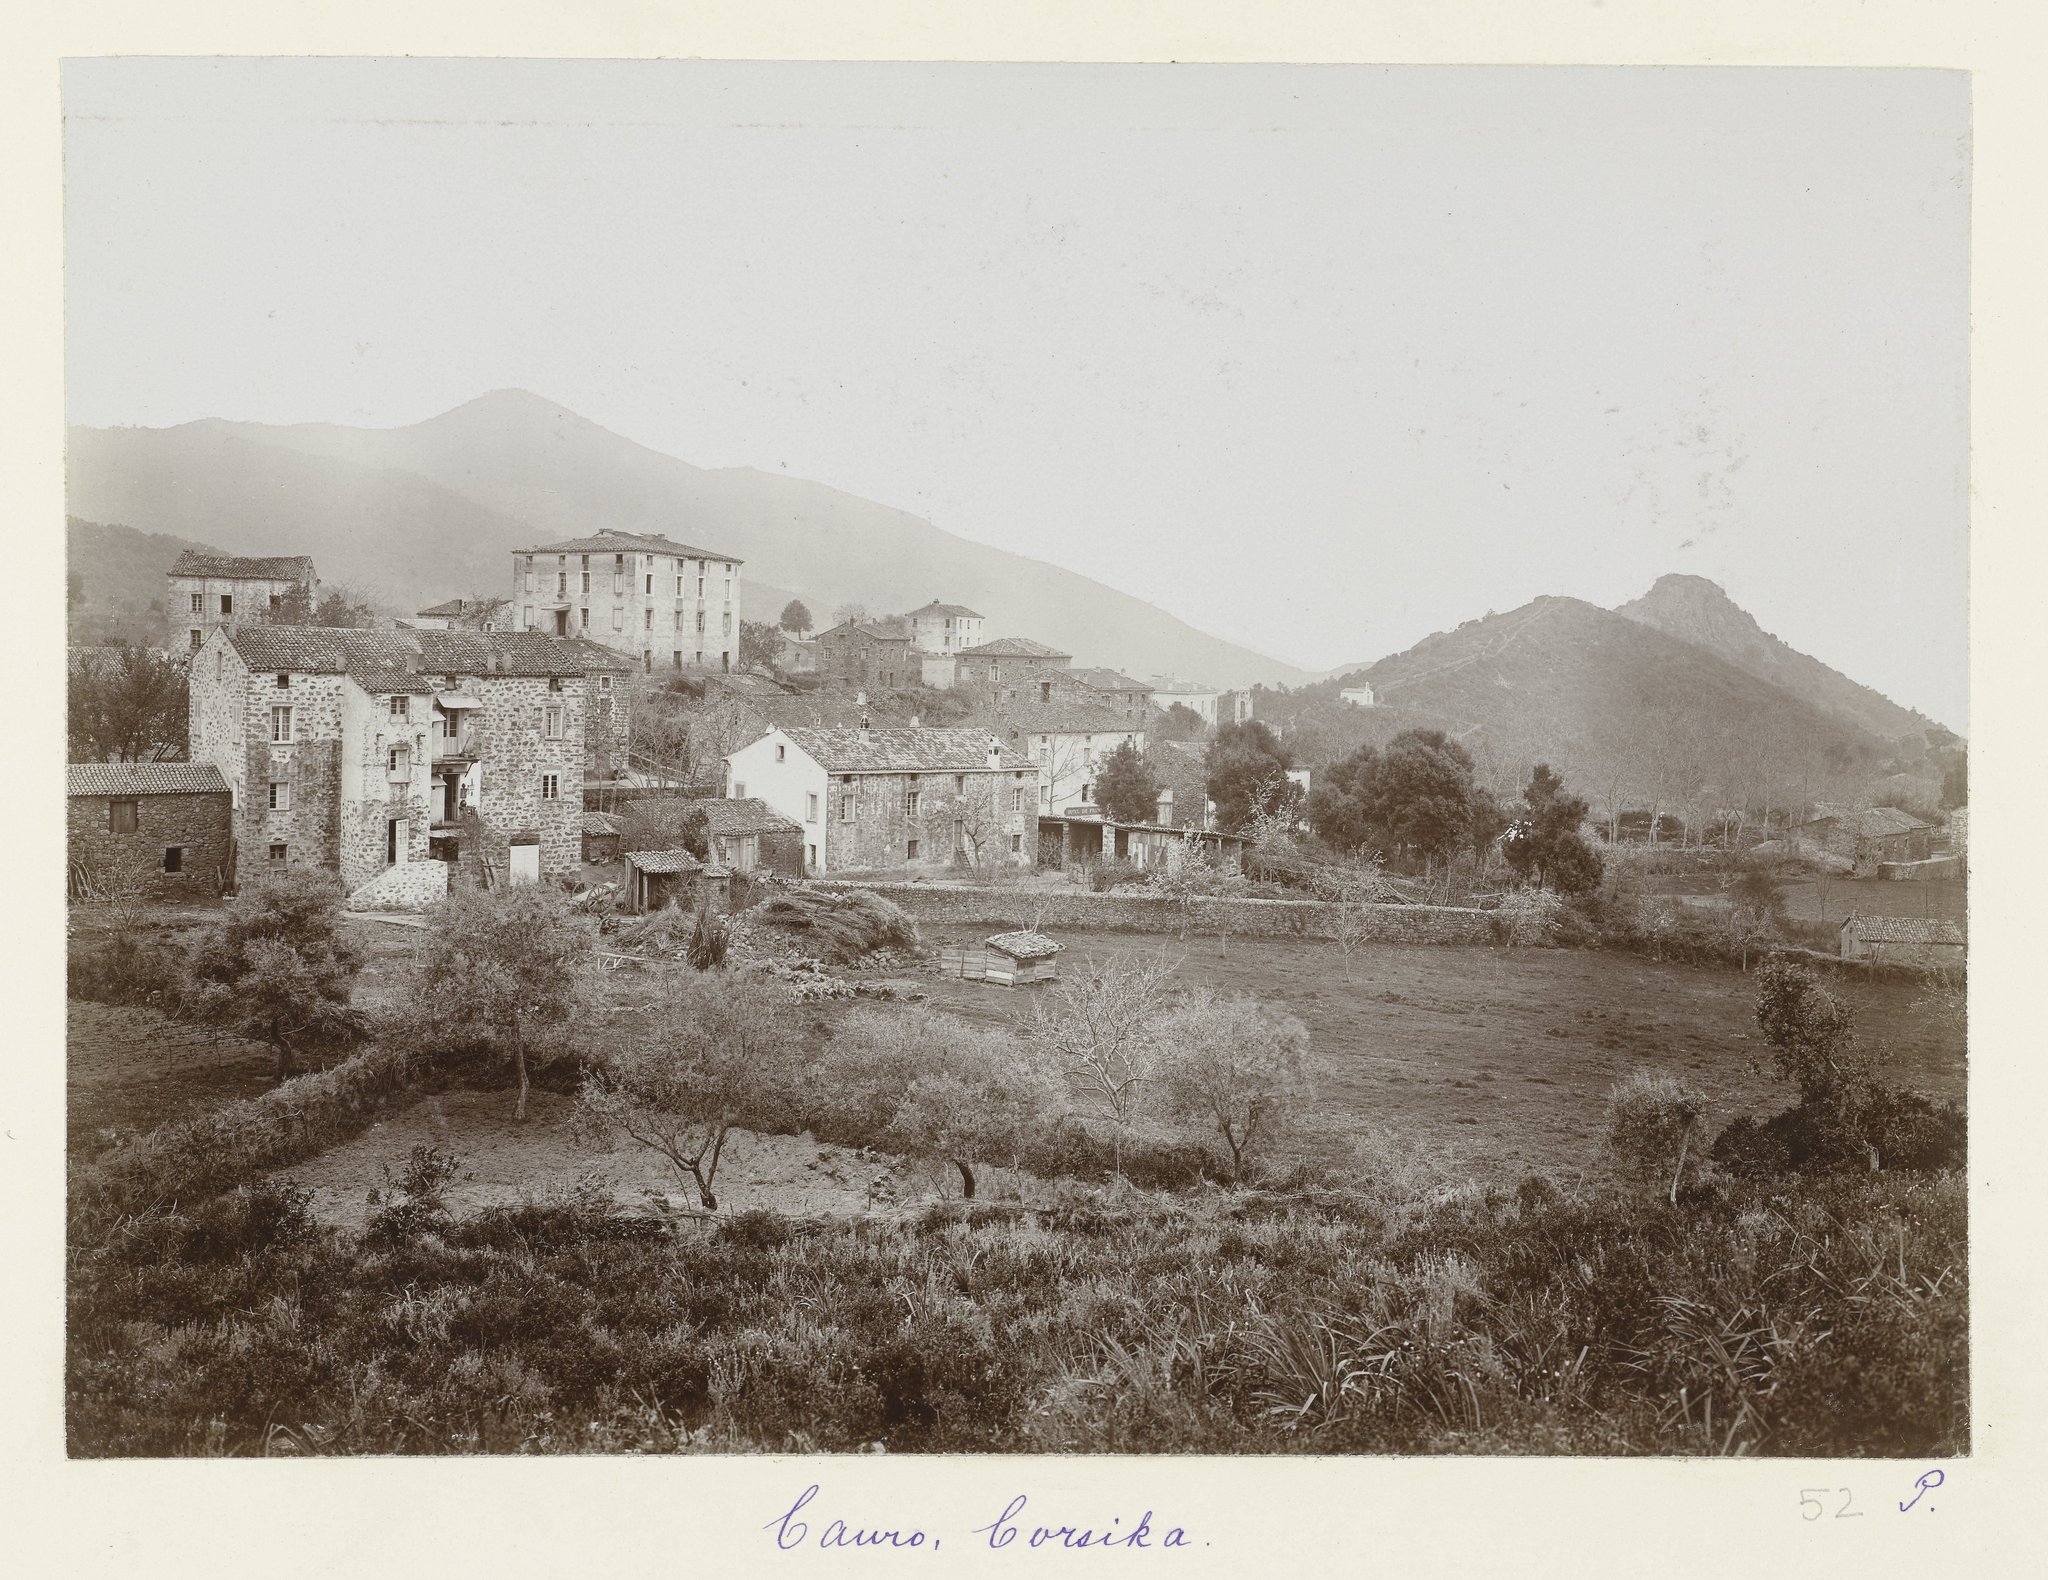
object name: photograph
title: Gezicht op het dorp Cauro op zuid Corsica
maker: henry pauw van wieldrecht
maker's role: fotograaf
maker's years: 1863-1912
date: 1886-1896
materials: cardboard, photographic support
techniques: albumen print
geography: corsica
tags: corsica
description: De stenen huizen in het heuvelachtige gebied van het zuid Corsicaanse dorp Cauro.